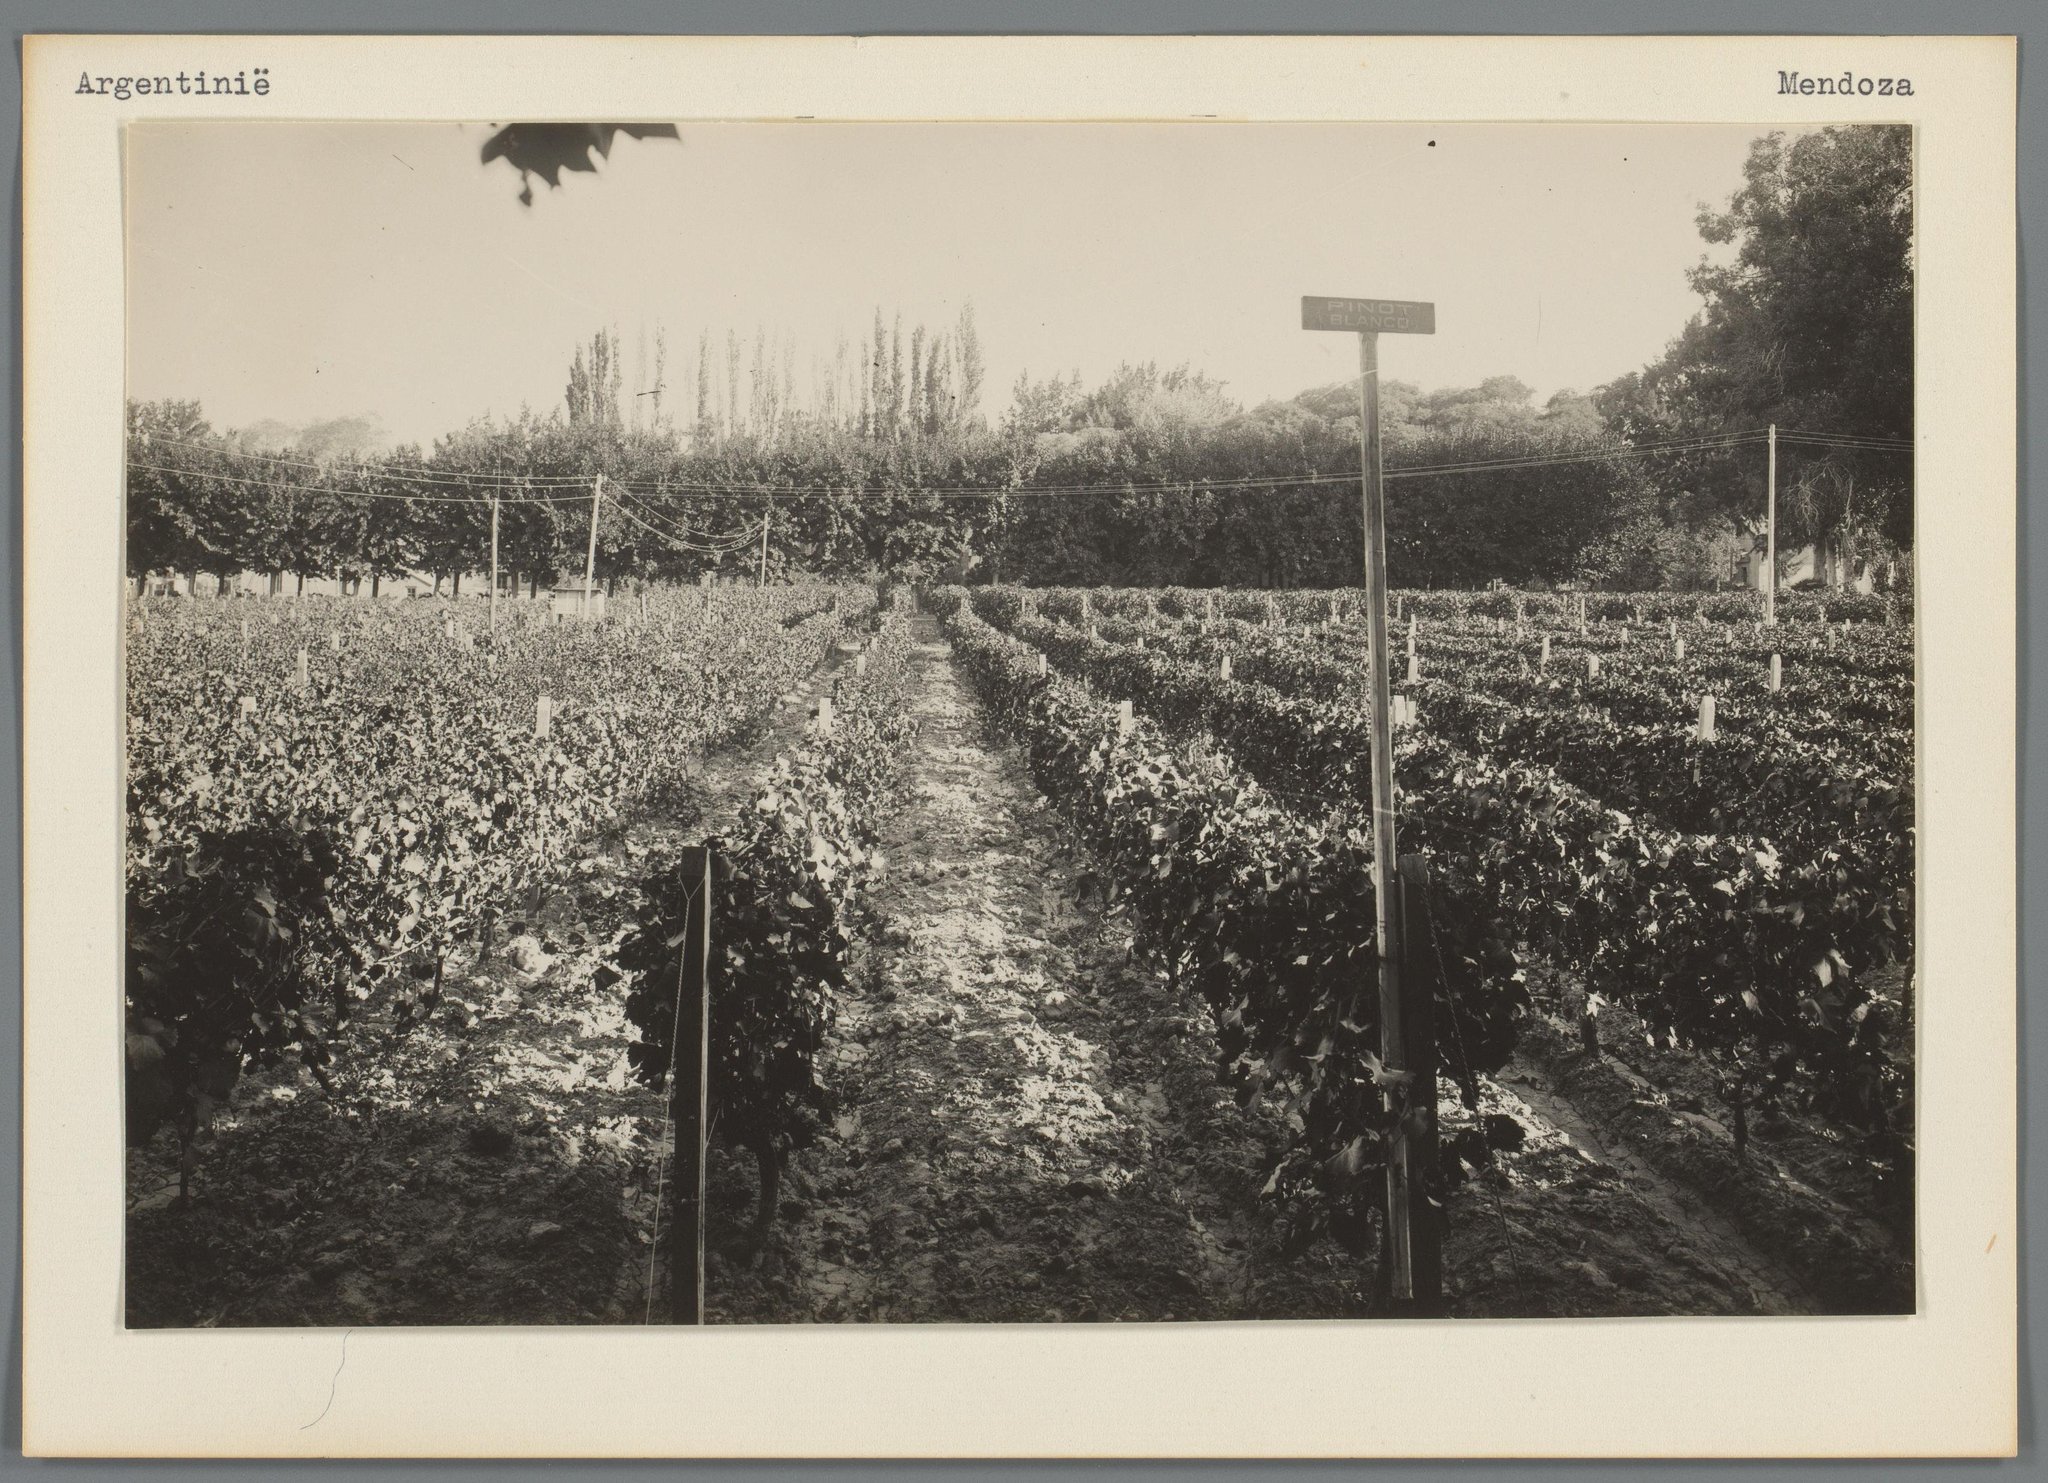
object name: photograph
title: Argentinië. Mendoza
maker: Anonymous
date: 1900-1930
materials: paper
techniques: gelatin silver print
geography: mendoza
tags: orchard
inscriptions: inscription: ‘Escuela (school) Vitivinicola Nacional/ Geplante wijnstokken’, number: ‘40.910’, inscription: ‘(1)/ Escuela Vitivinícola Nacional de Mendoza. Viñedos en el primer plano/ espalderas de tres alambres, en el segundo plano contraespalderas de/ alambres, en el tercero avenida de moreras./ (1) Ecole Nationale de viticulture à Mendoza. Plantation de vigne en’, stamp: ‘REPÚBLICA ARGENTINA/ MINISTERIO D'AGRICULTURA DE LA MACIOR/ [...]/ DIVISION FOTO-CINEMATOGRAFIA’, number: ‘970000’, number: ‘1125.’